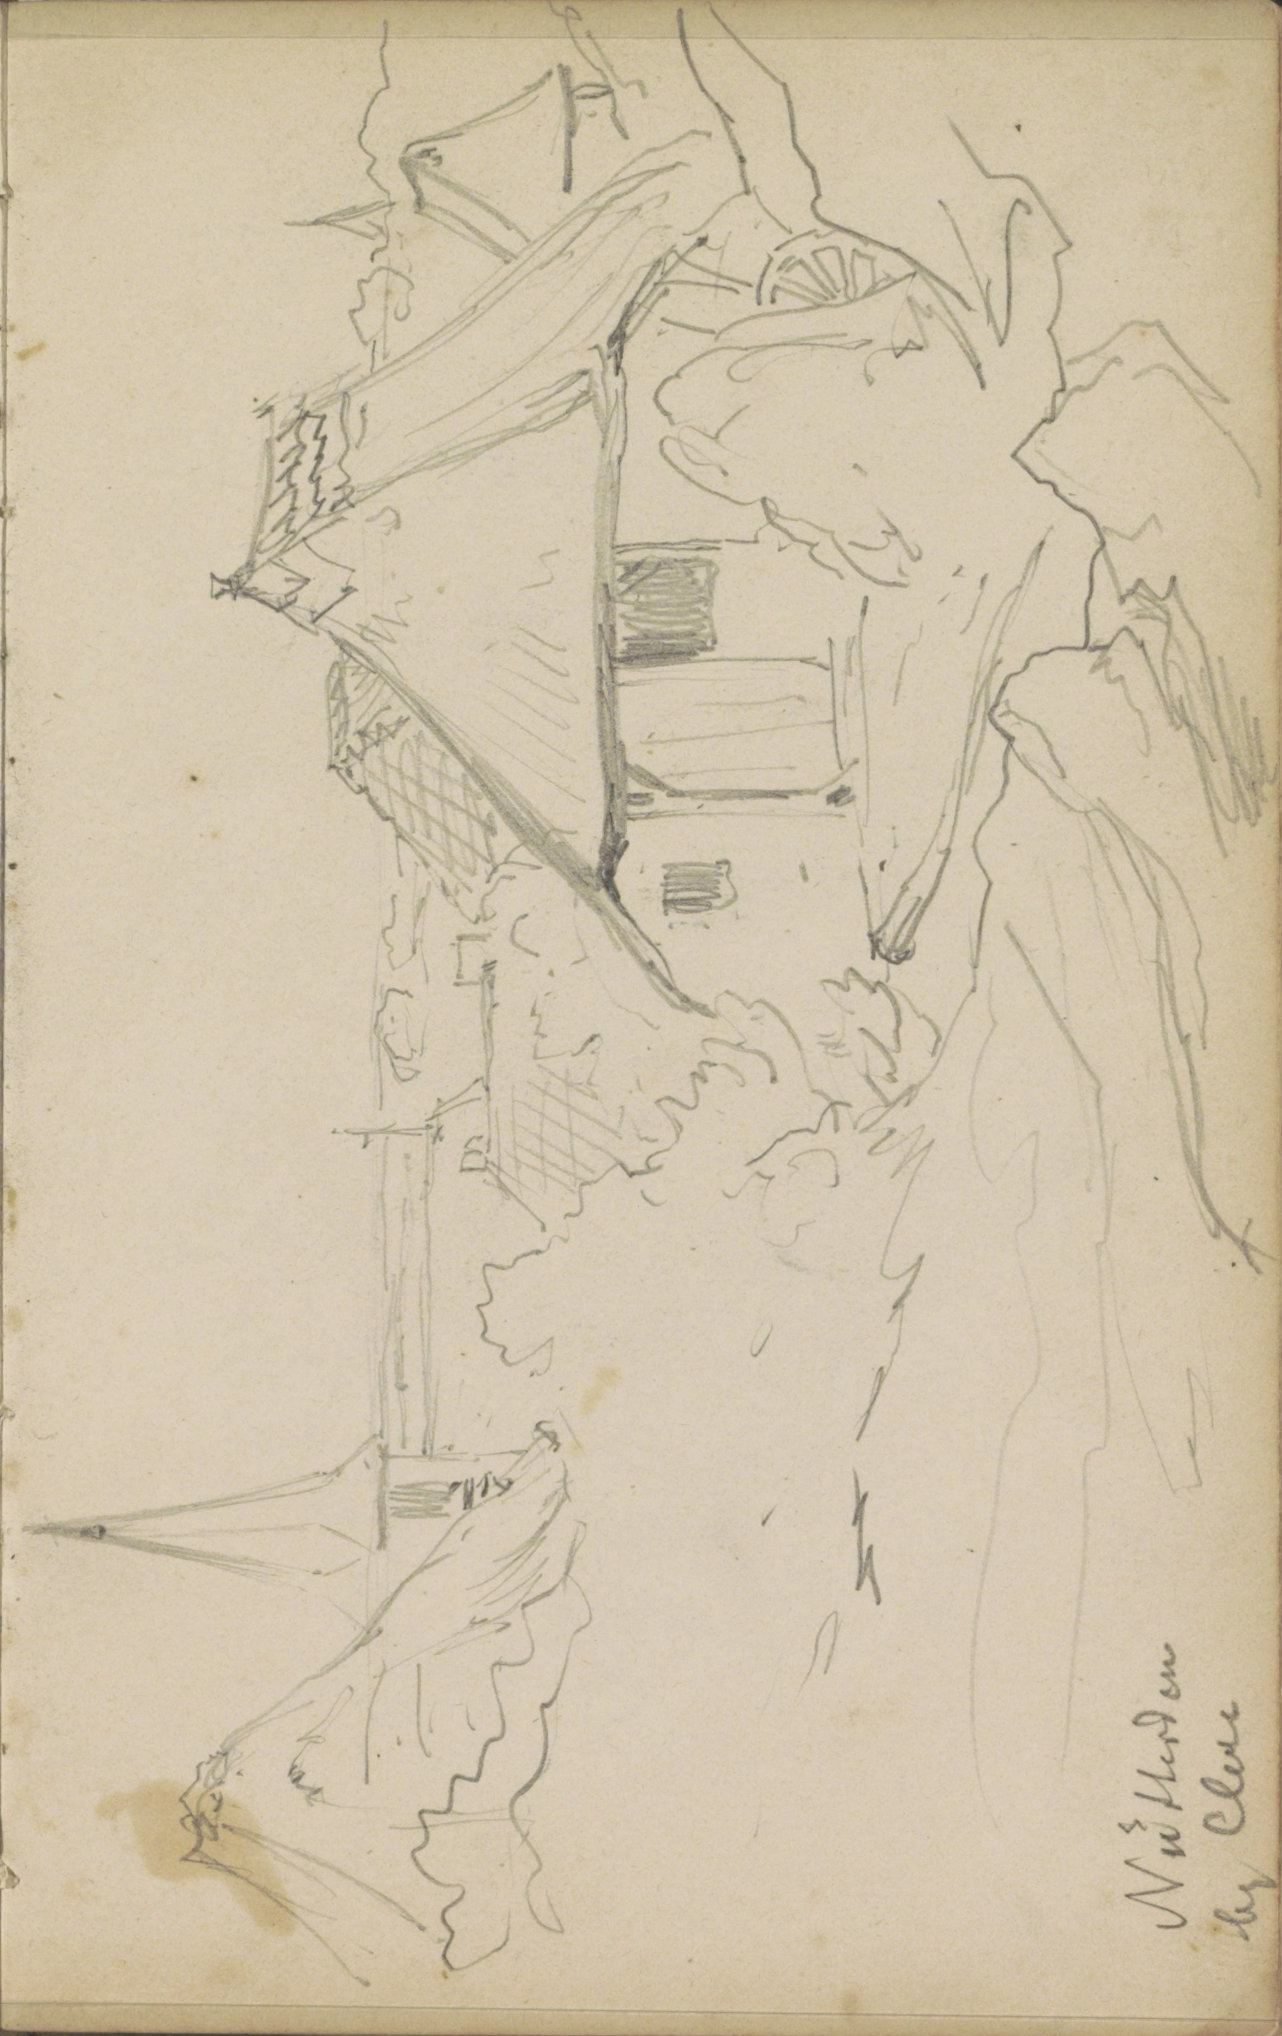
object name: sketchbook leaf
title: Dorp bij Kleef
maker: johannes tavenraat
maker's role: draughtsman, painter, print maker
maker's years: 1809-1881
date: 1839-1872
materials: paper, pencil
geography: cleves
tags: city-view, and landscape with man-made constructions, road, path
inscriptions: annotation: ‘Nu[...]Herden/ bij Cleve’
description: Blad 52 recto uit een schetsboek met 73 bladen.